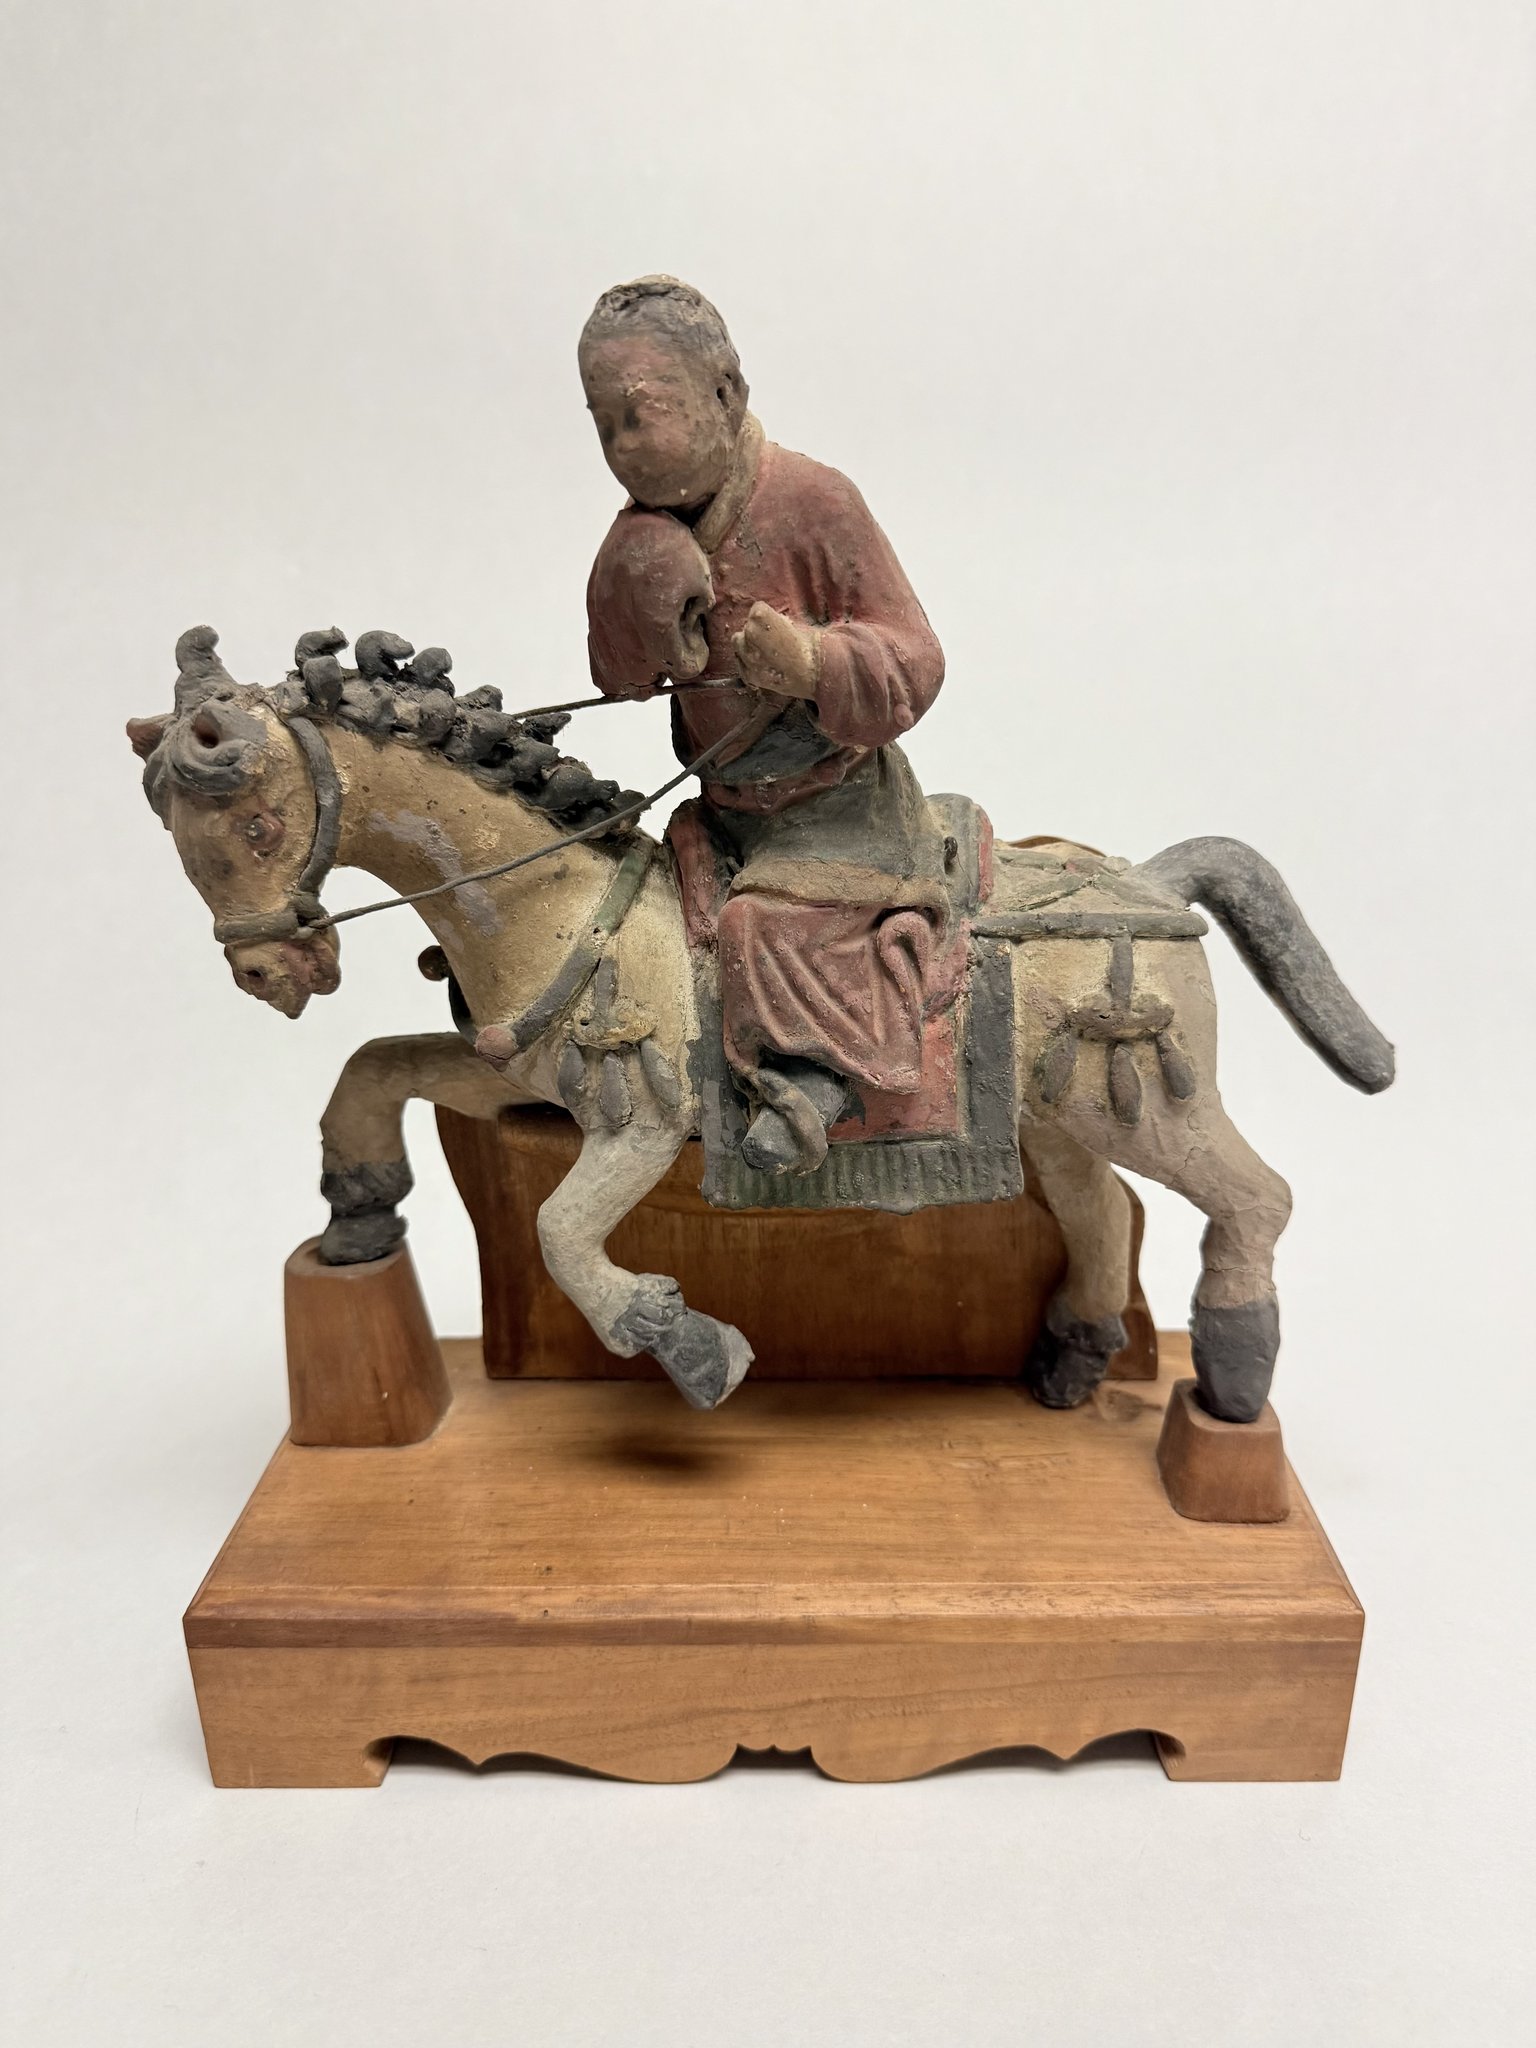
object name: figure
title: Horse and Rider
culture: chinese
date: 1368-1644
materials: clay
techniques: painting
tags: men,horses